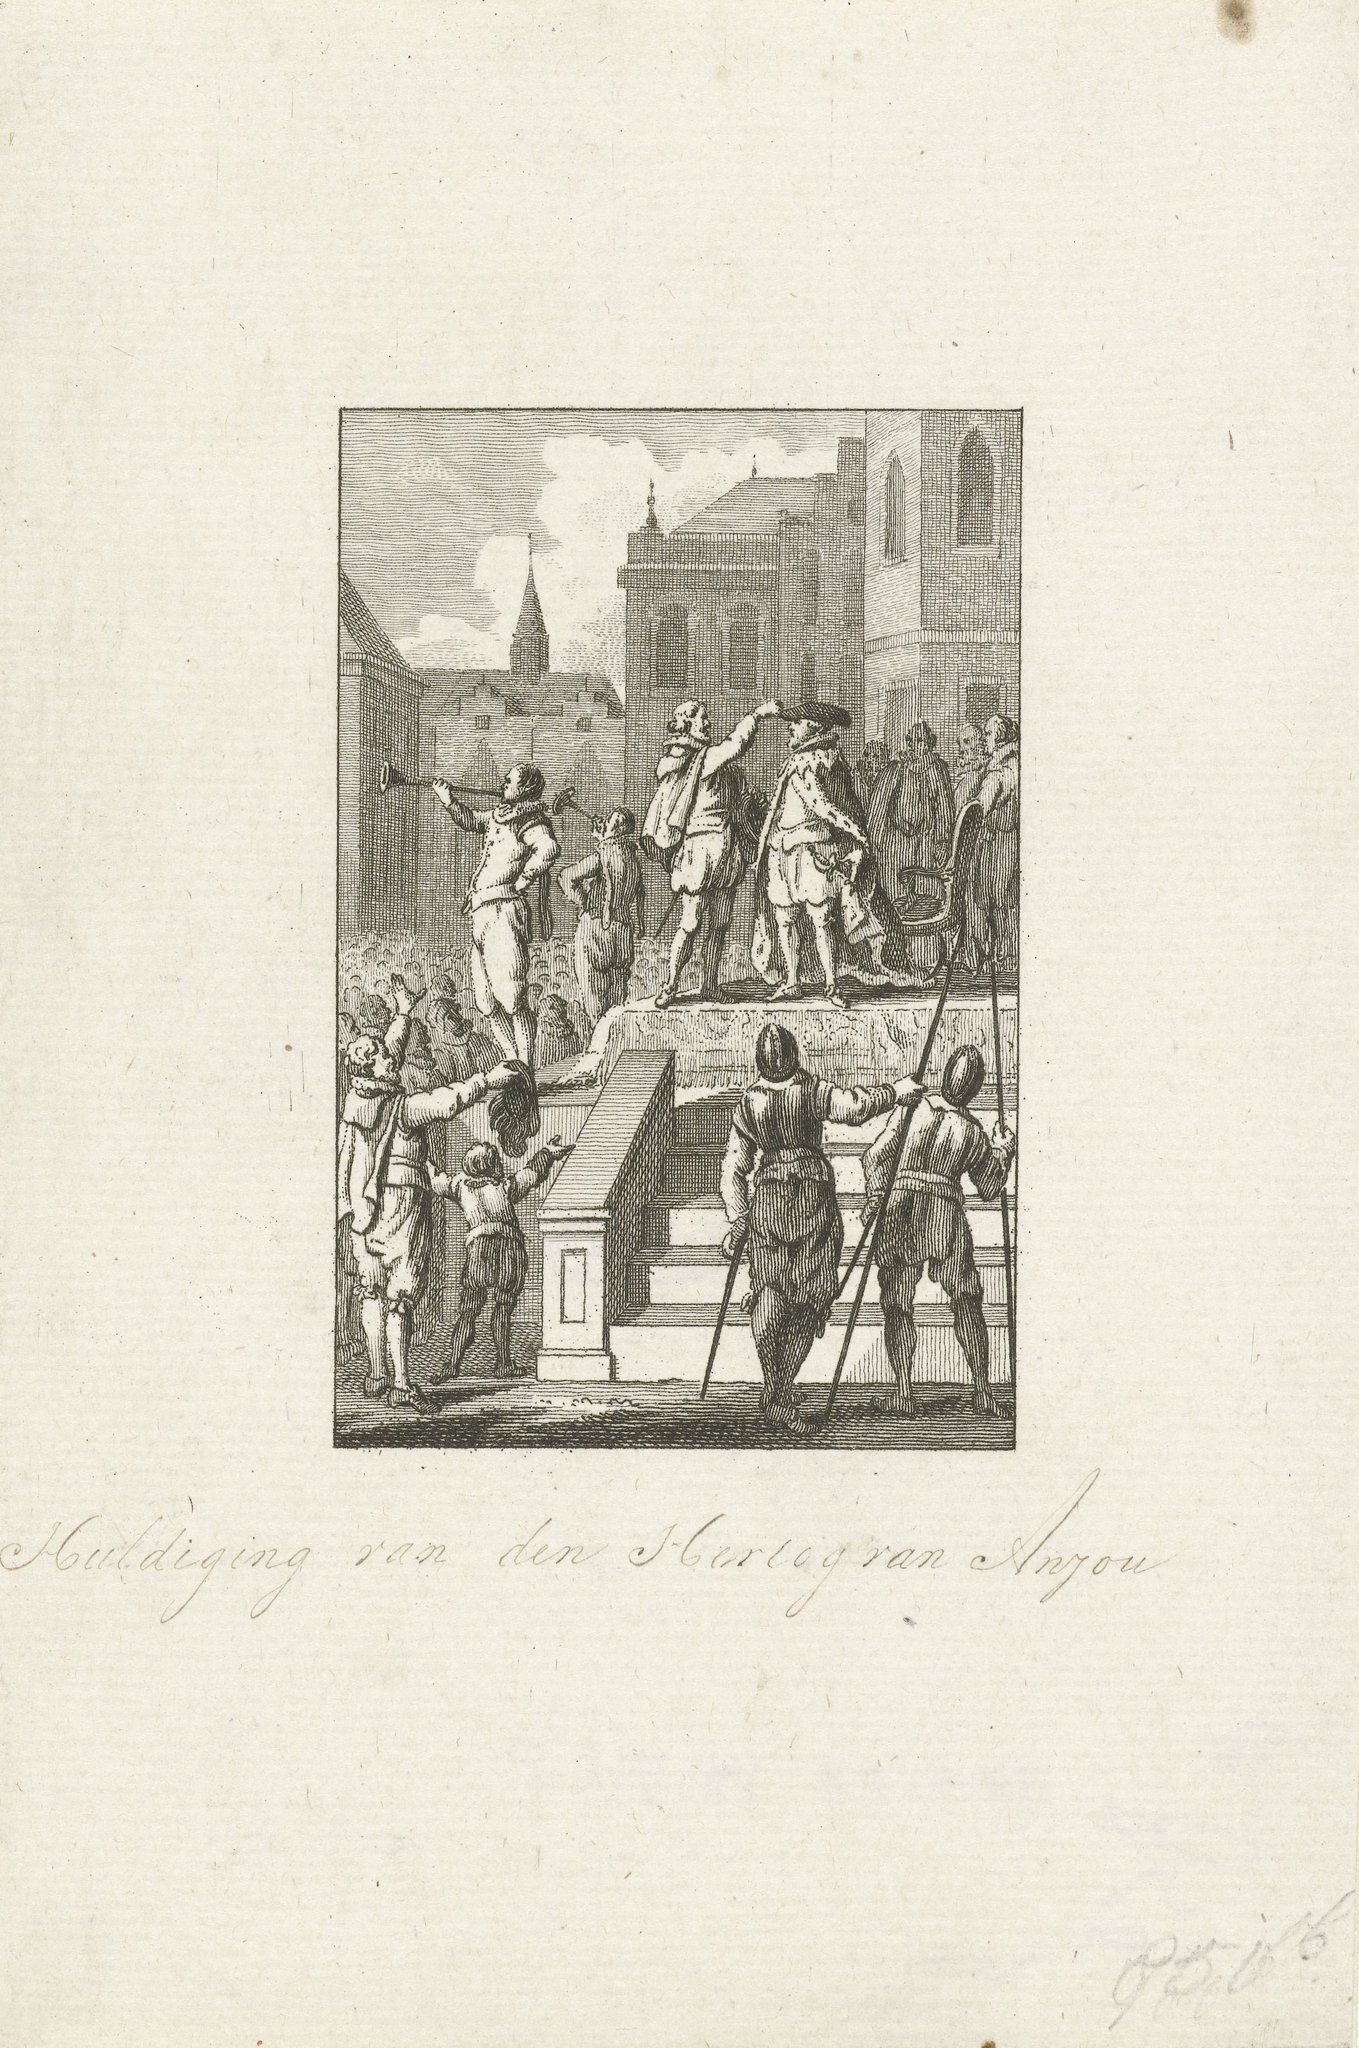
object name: history print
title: De hertog van Anjou gehuldigd te Antwerpen, 1582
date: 1780-1795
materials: paper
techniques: etching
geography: netherlands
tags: paris, françois-hercule de valois (hertog van anjou), triumphal entry and public reception, pageant, 'entrée solennelle', 'joyeuse entrée', antwerp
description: Gebruikt als illustratie in: J. Fokke, Geschiedenissen der Vereenigde Nederlanden voor de vaderlandsche jeugd, Johannes Allart, Amsterdam 1783-1795, 25 delen, dl. V, pl. V.